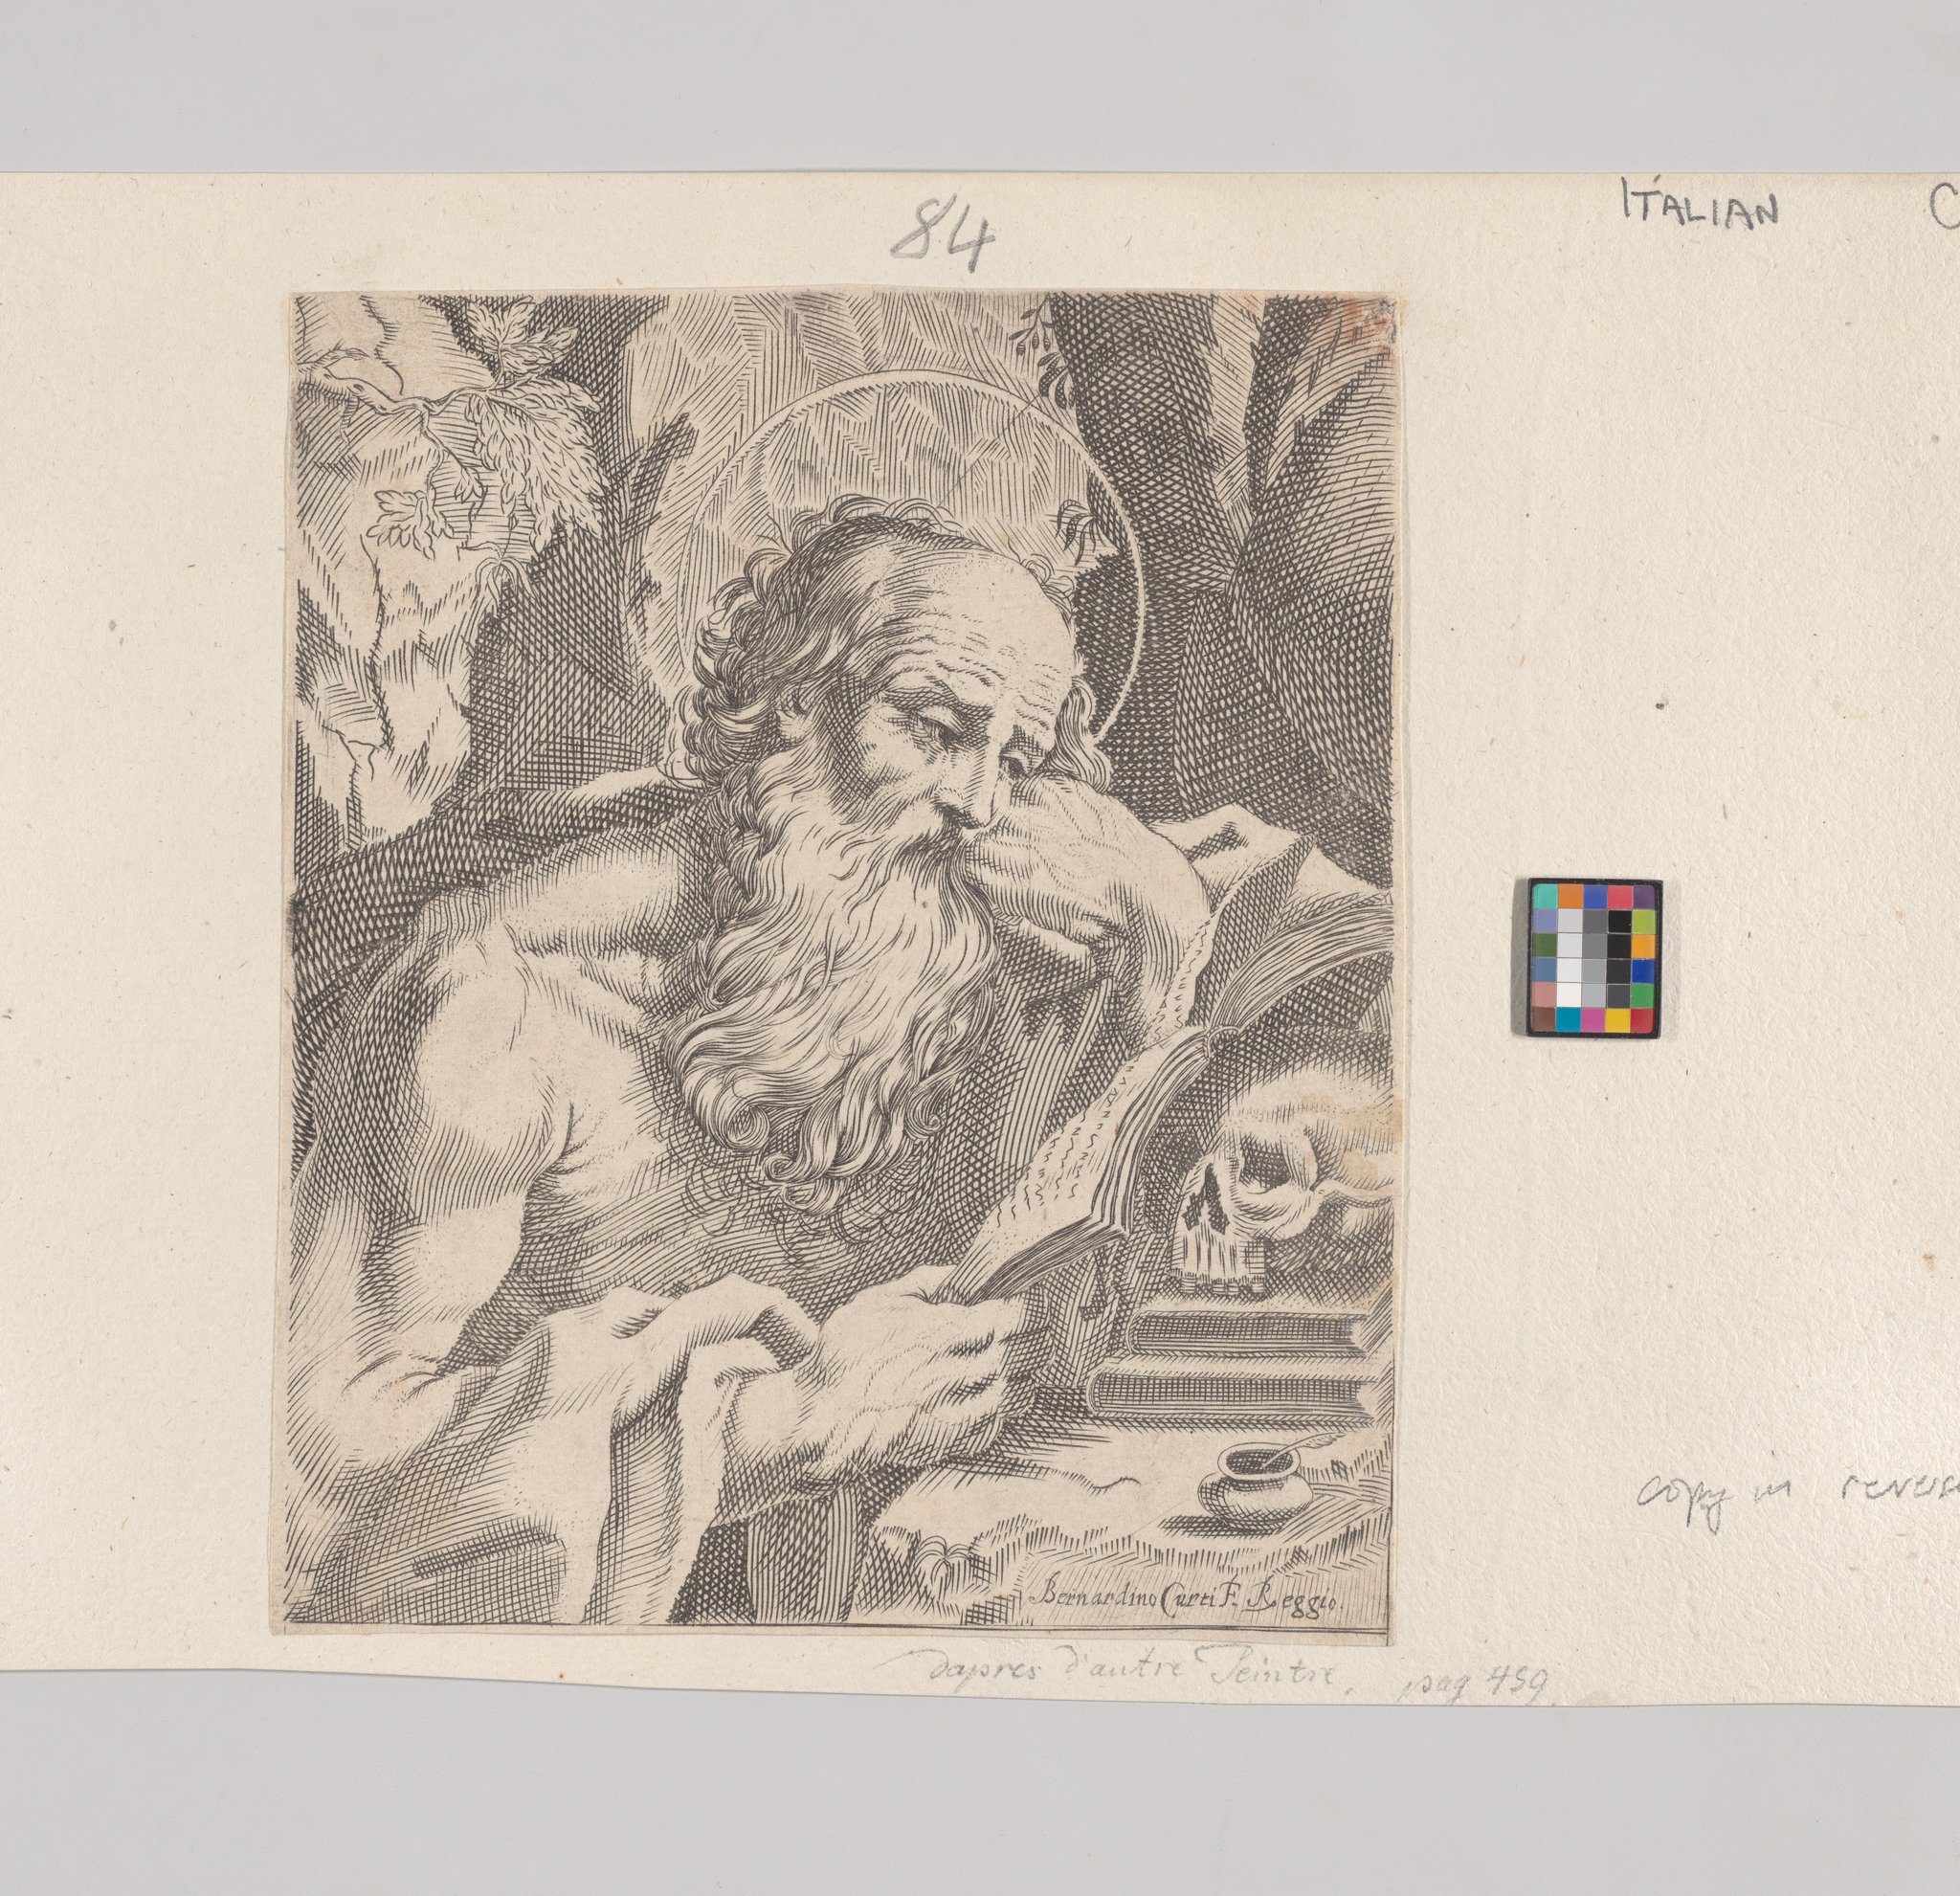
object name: print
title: Saint Jerome Reading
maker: bernardino curti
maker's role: artist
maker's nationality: italian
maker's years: 1611-1679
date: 1630-1679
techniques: engraving, etching